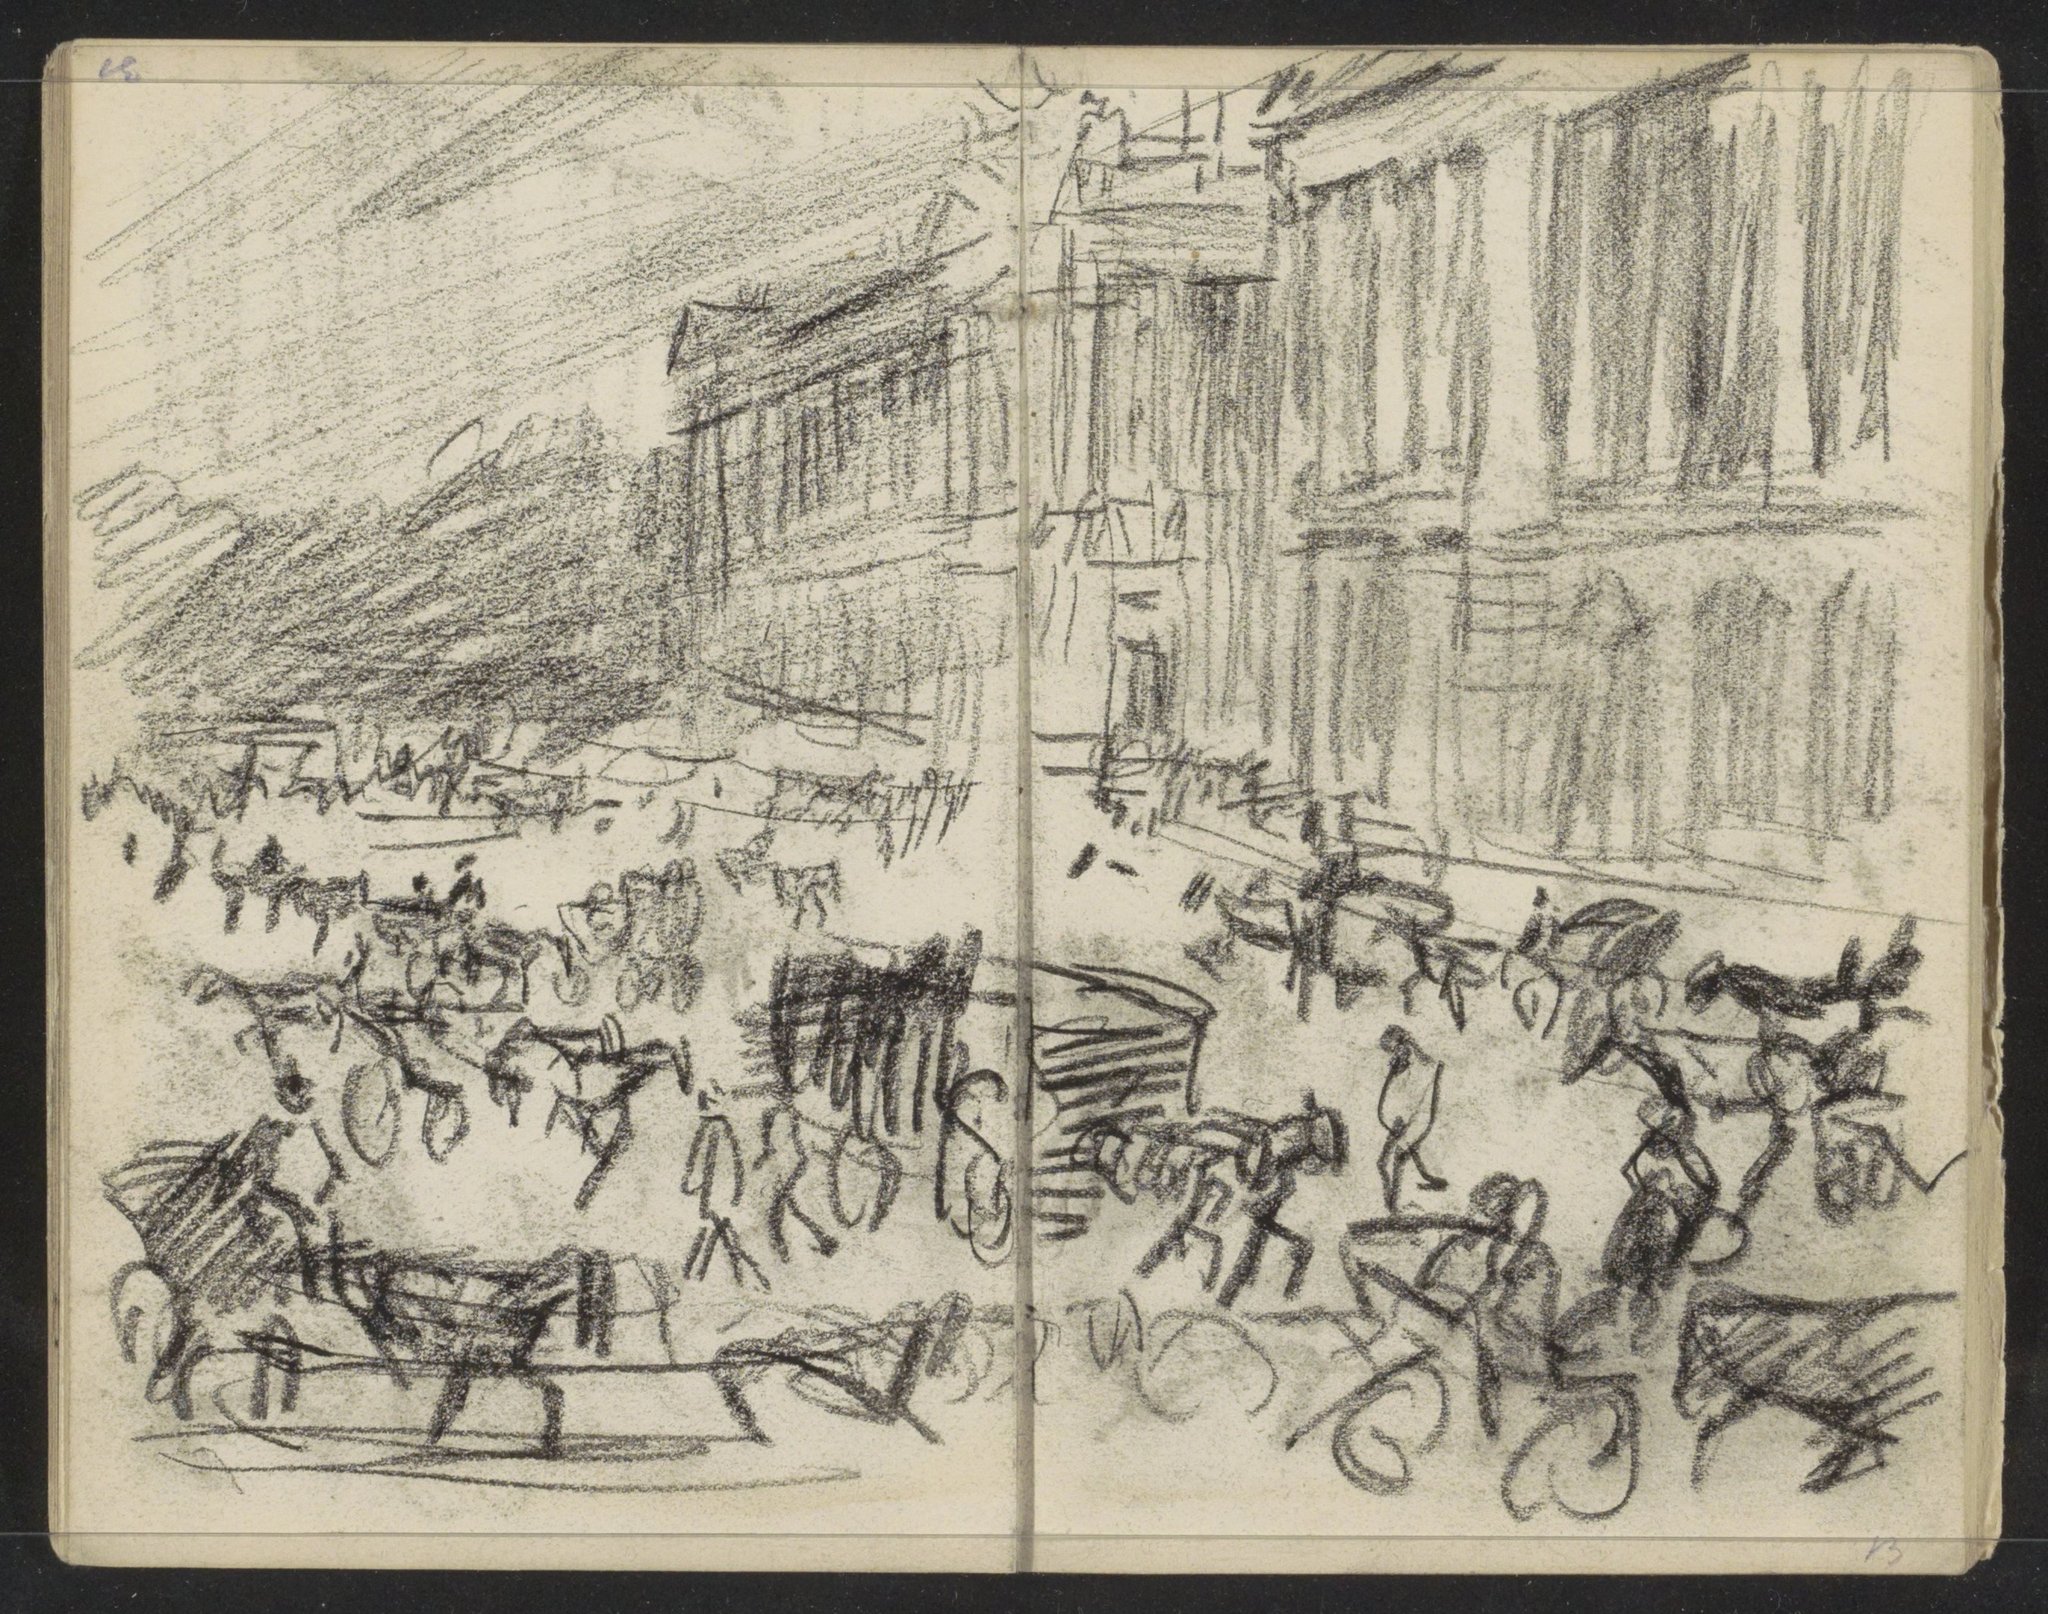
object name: sketchbook leaf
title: Rijtuigen op een plein in Parijs, mogelijk het Place de la Concorde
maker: isaac israels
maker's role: draughtsman, painter, print maker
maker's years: 1865-1934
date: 1887-1934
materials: chalk, paper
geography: paris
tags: square, place, circus, etc., four-wheeled, animal-drawn vehicle, e.g.: cab, carriage, coach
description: Blad 12 verso en blad 13 recto uit schetsboek LIX met 21 bladen.